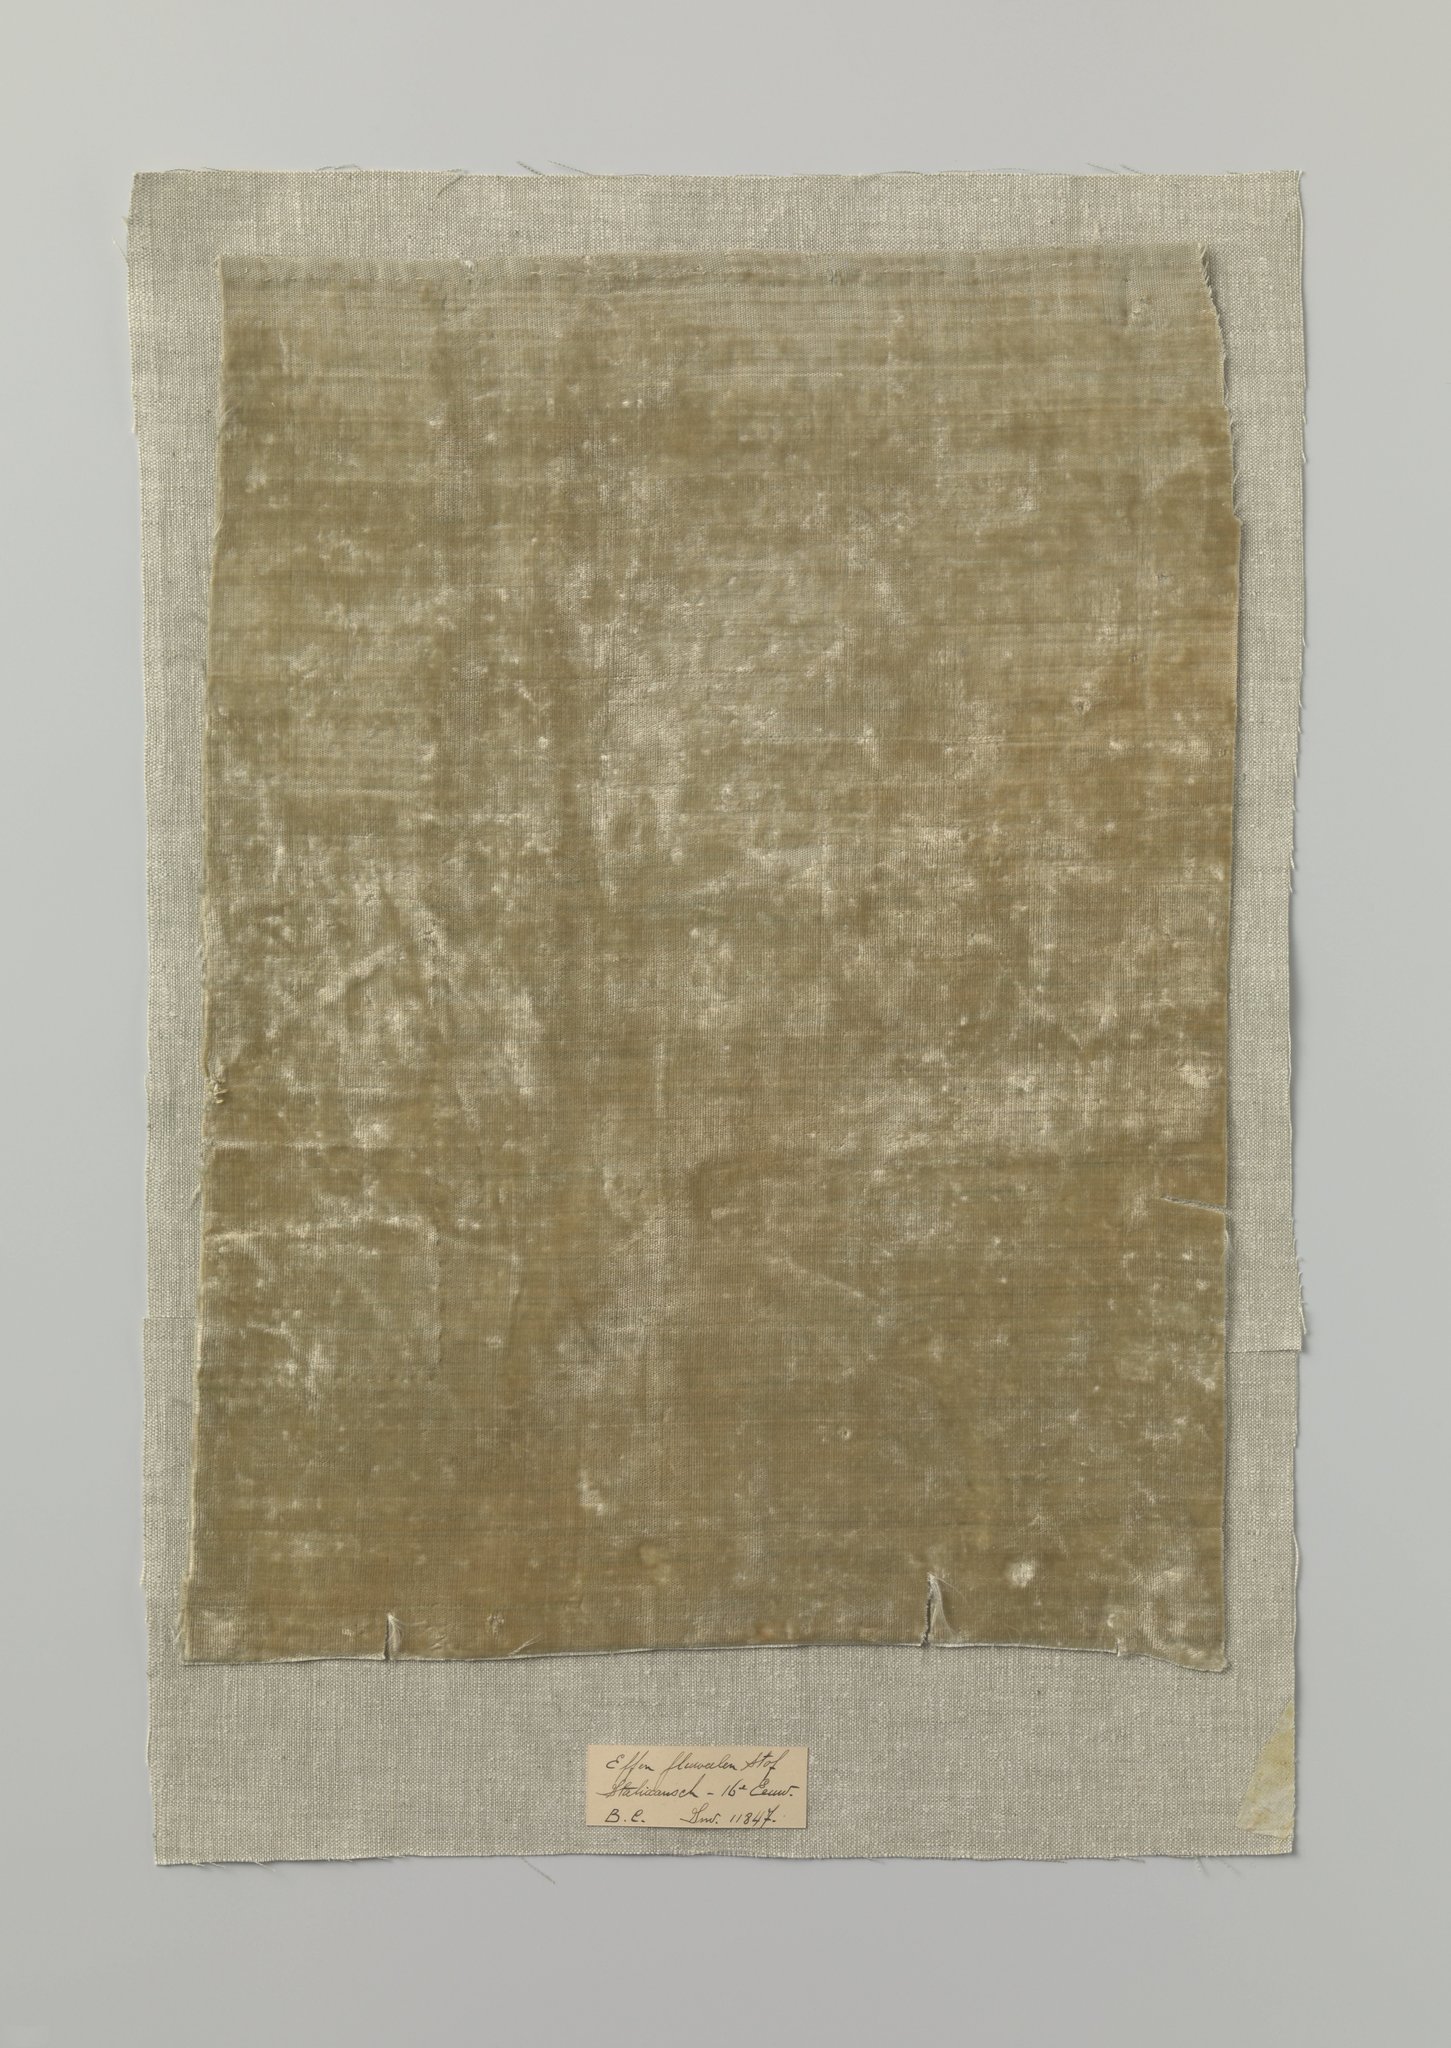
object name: zijdefluweel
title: Fragment zijdefluweel in beige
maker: Anonymous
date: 1500-1599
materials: silk, velvet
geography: italy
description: Fragment zijdefluweel in groengeel. Geen decoratie. Italië, 16de eeuw.